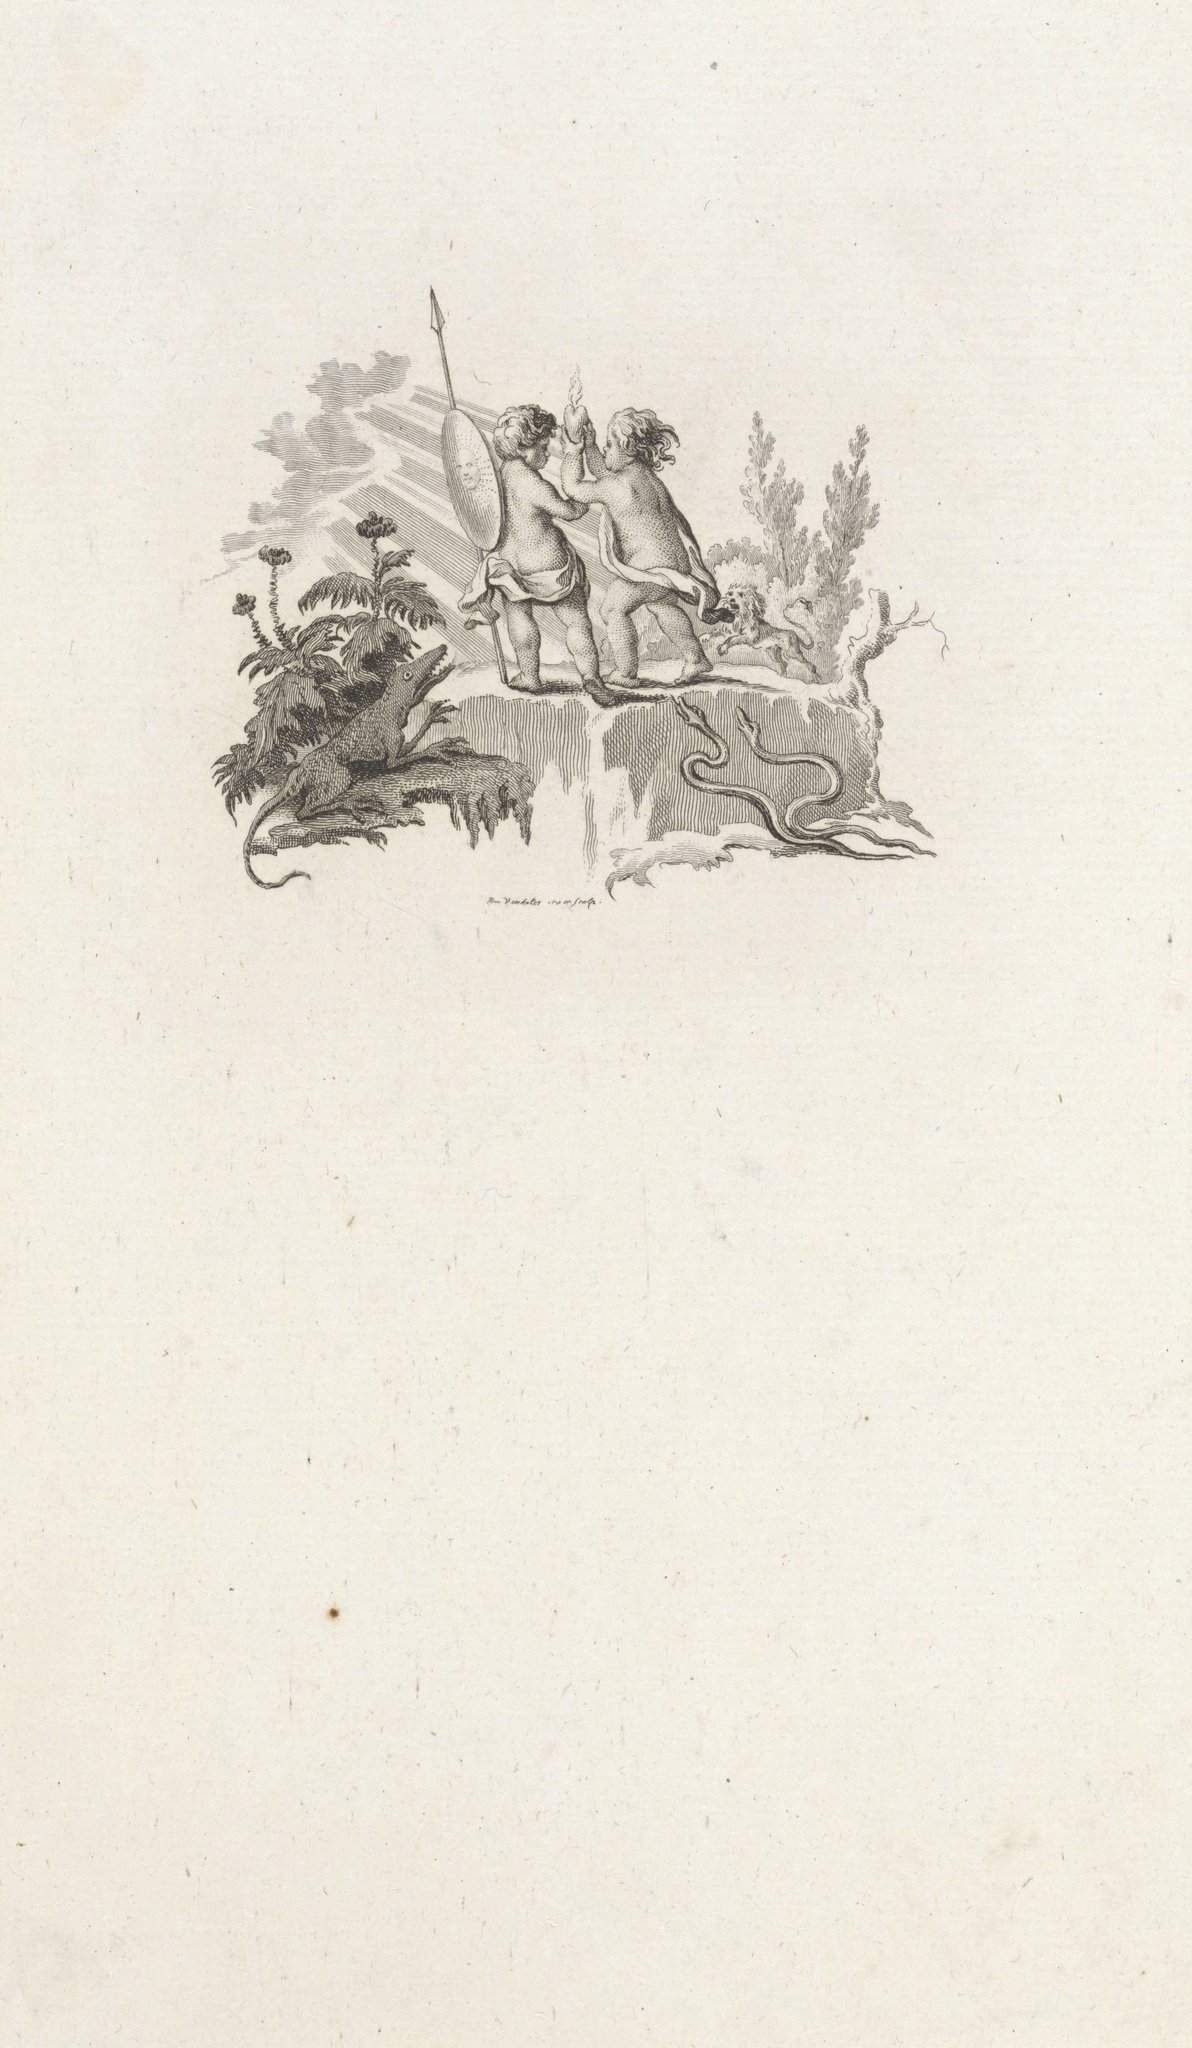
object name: print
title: Vignet met twee putti met een brandend hart in een gevaarlijk gebied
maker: reinier vinkeles (i)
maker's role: draughtsman, print maker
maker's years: 1741-1816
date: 1751-1816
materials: paper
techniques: etching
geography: amsterdam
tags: snakes, heart symbolism, beasts of prey, predatory animals: lion, cupids: 'amores', 'amoretti', 'putti'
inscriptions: collector's mark: Lugt 240